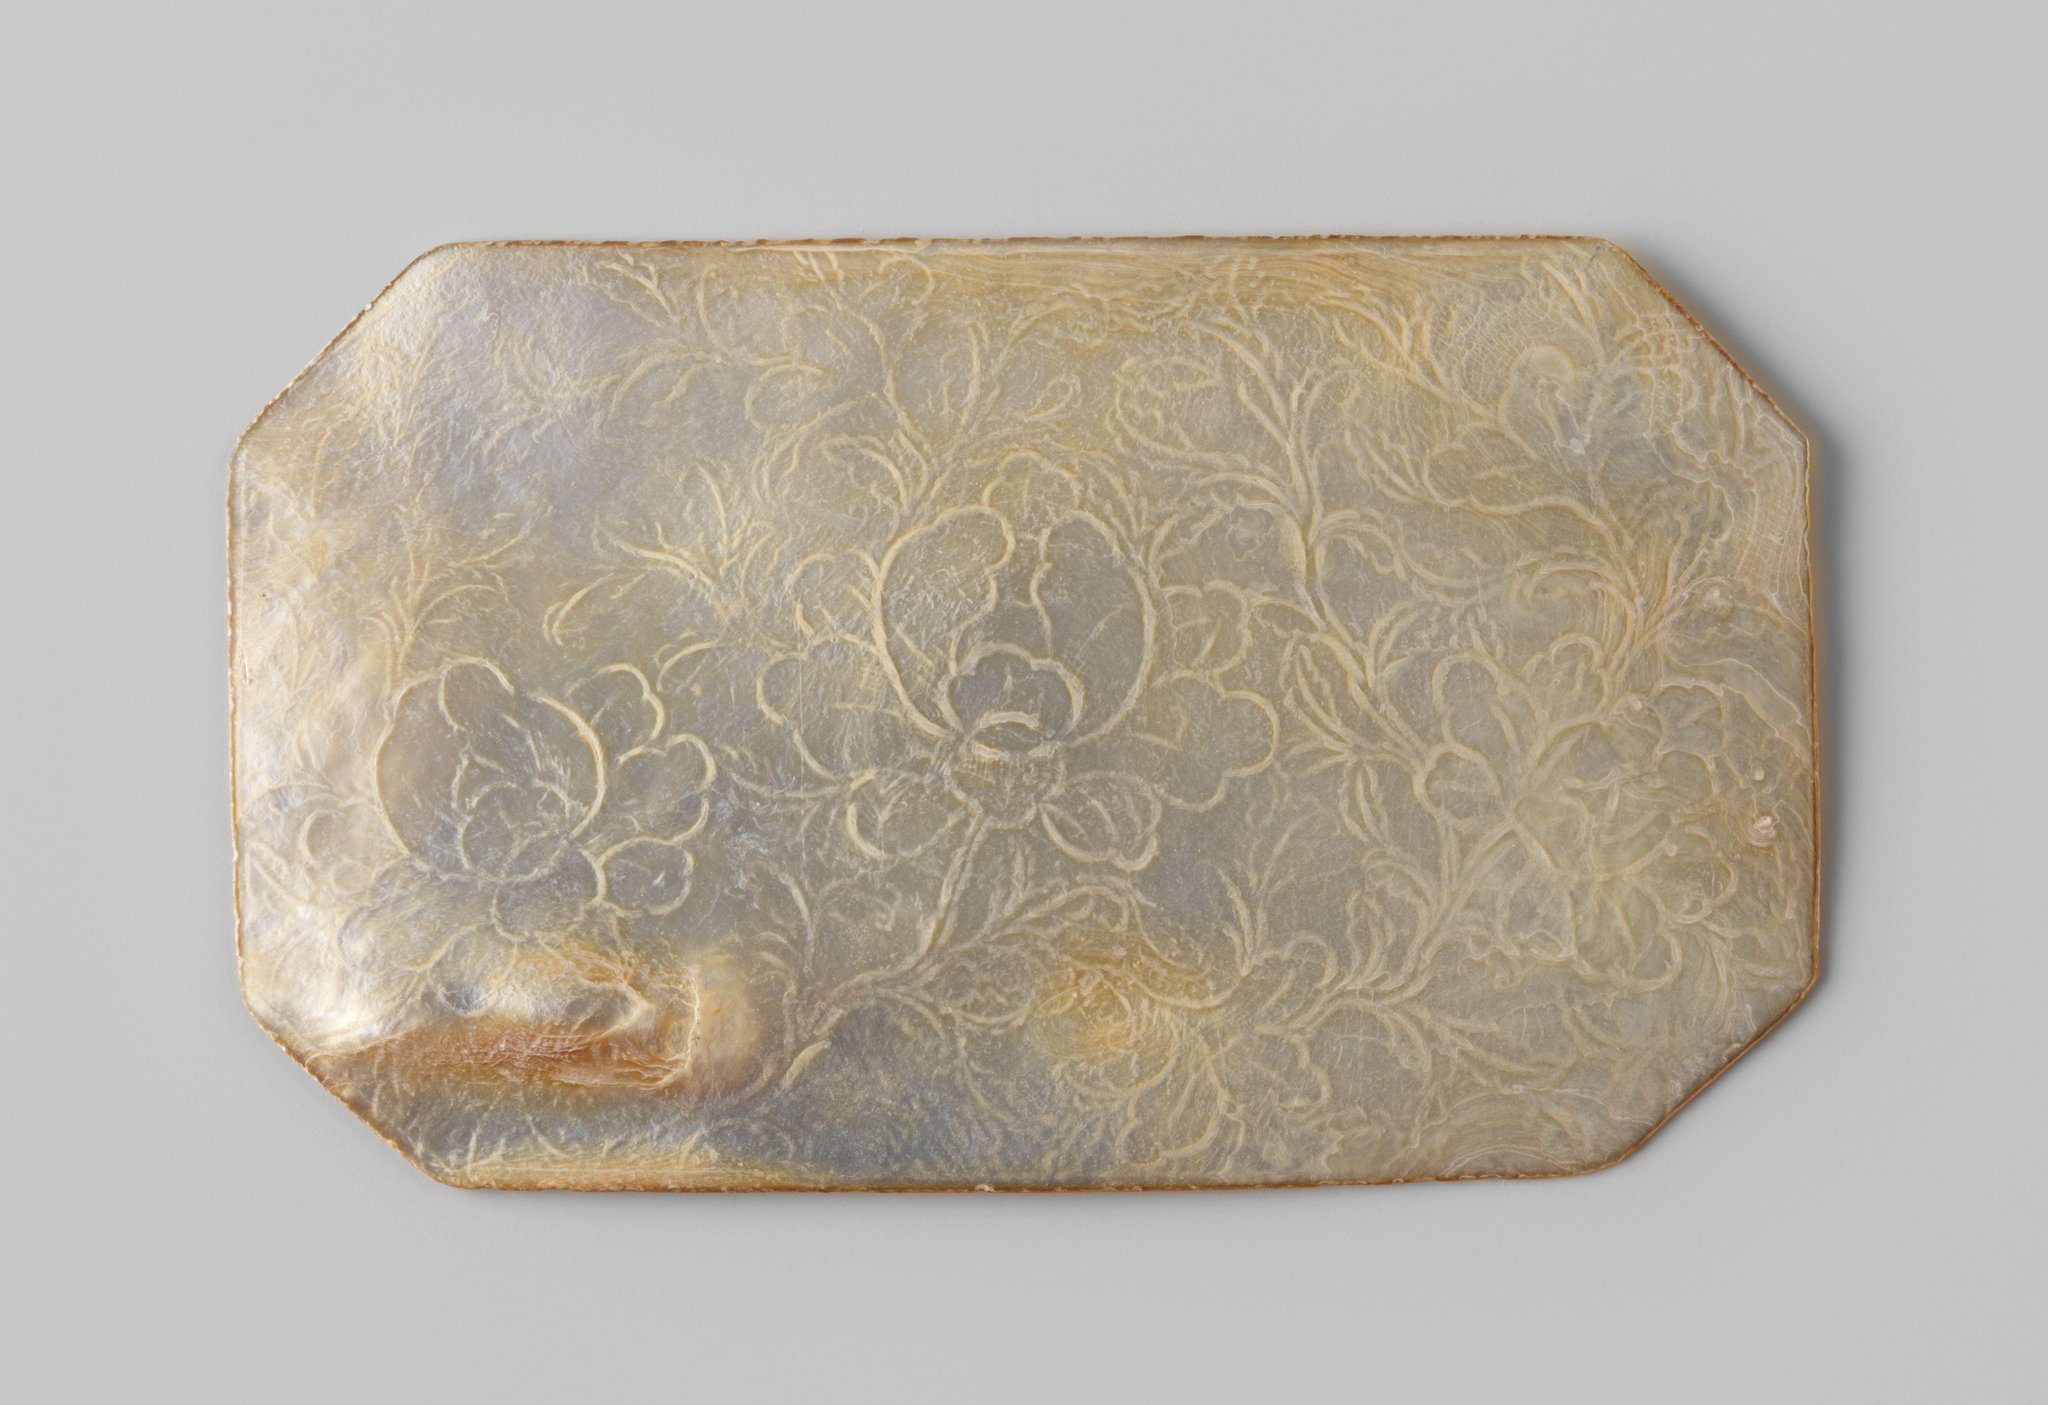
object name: lid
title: Lid or bottom of a snuffbox of mother of pearl from the wreck of the Dutch East Indiaman 't Vliegend Hart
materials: mother of pearl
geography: middelburg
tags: 't vliegend hart (schip), verenigde oostindische compagnie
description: Paarlmoeren deksel of bodem van een snuifdoos. In VOC-opstelling met gelijkend deel met vondstnummer V83-185.